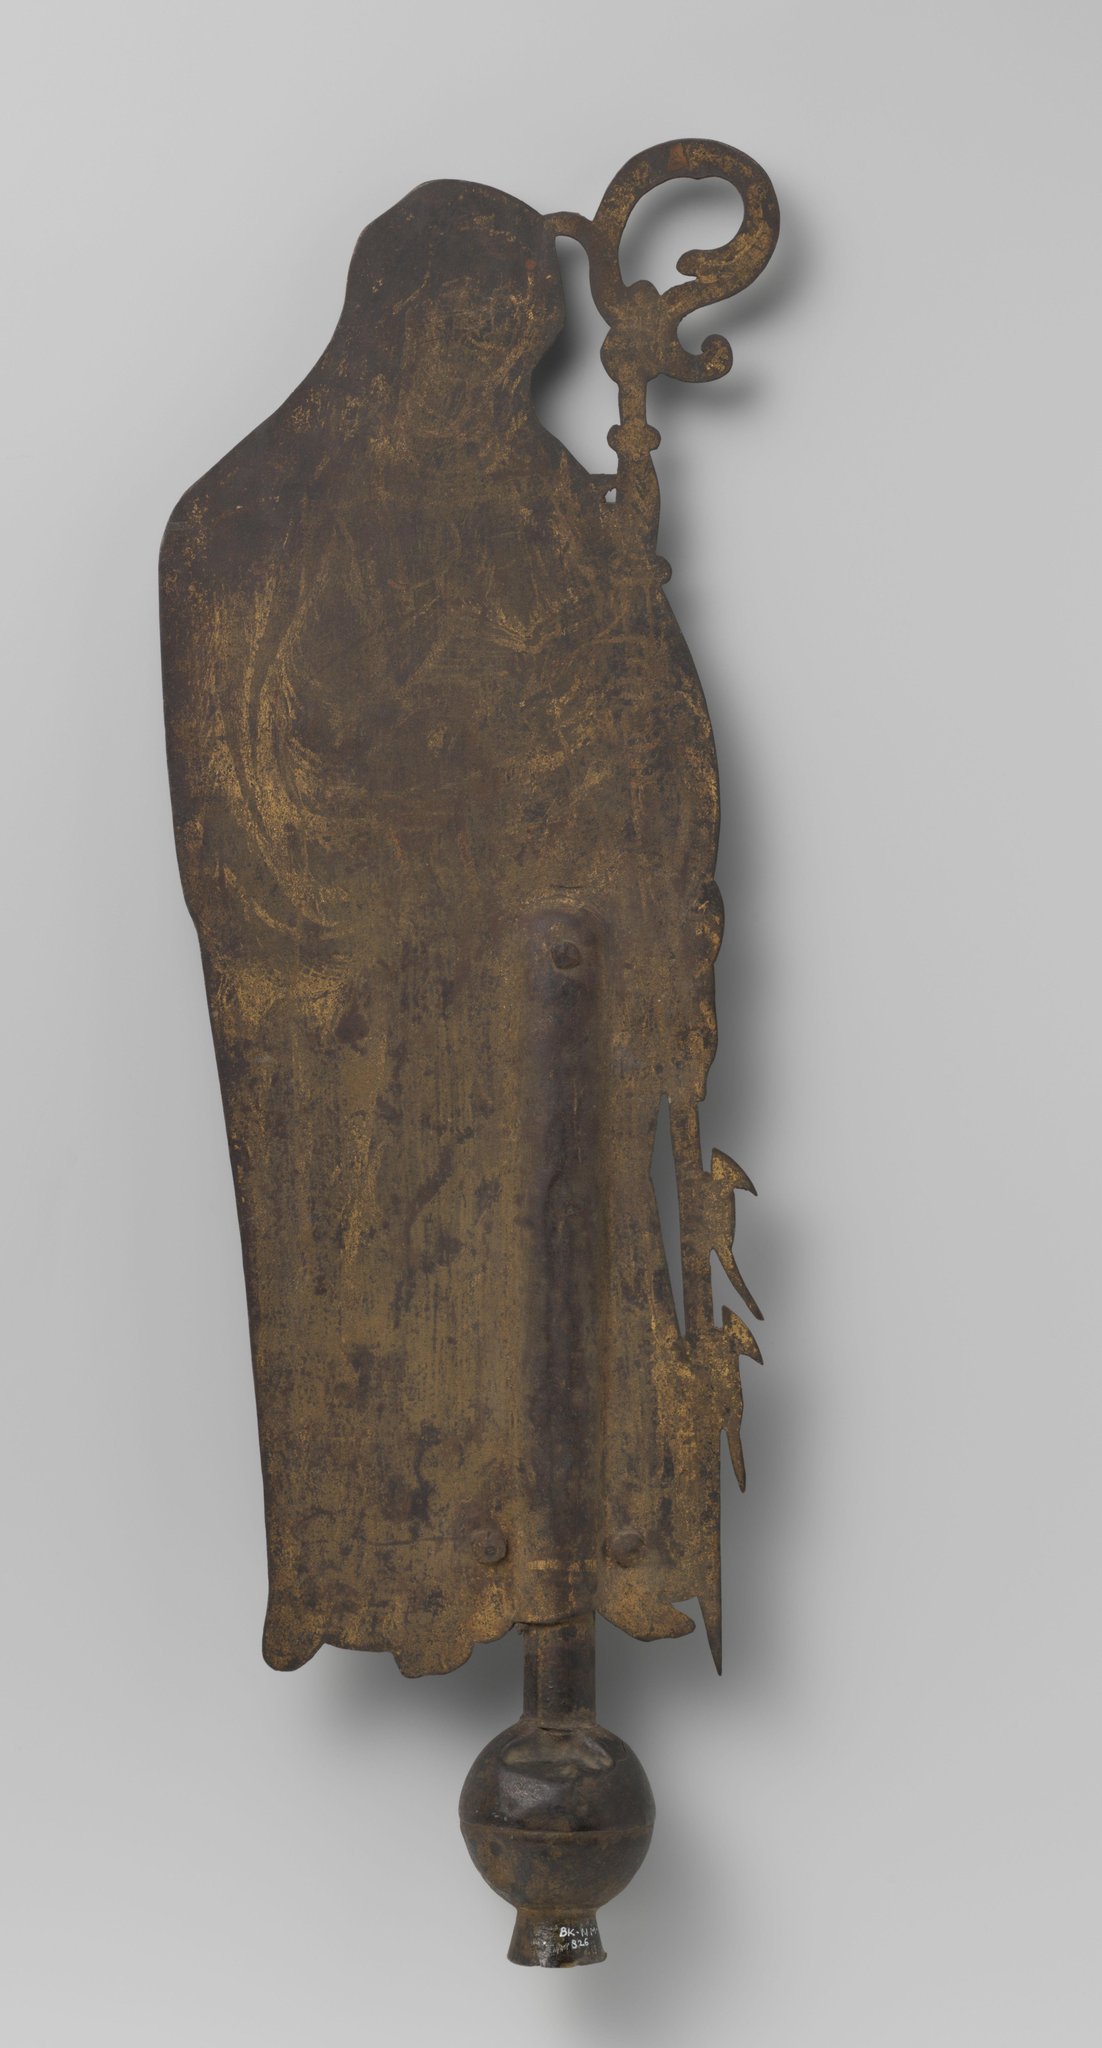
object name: weather vane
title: Windwijzer in de vorm van de heilige Gertruda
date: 1400-1950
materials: copper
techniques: gilding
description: Windwijzer van verguld koper in de vorm van een beeld, voorstellende Gertruda.